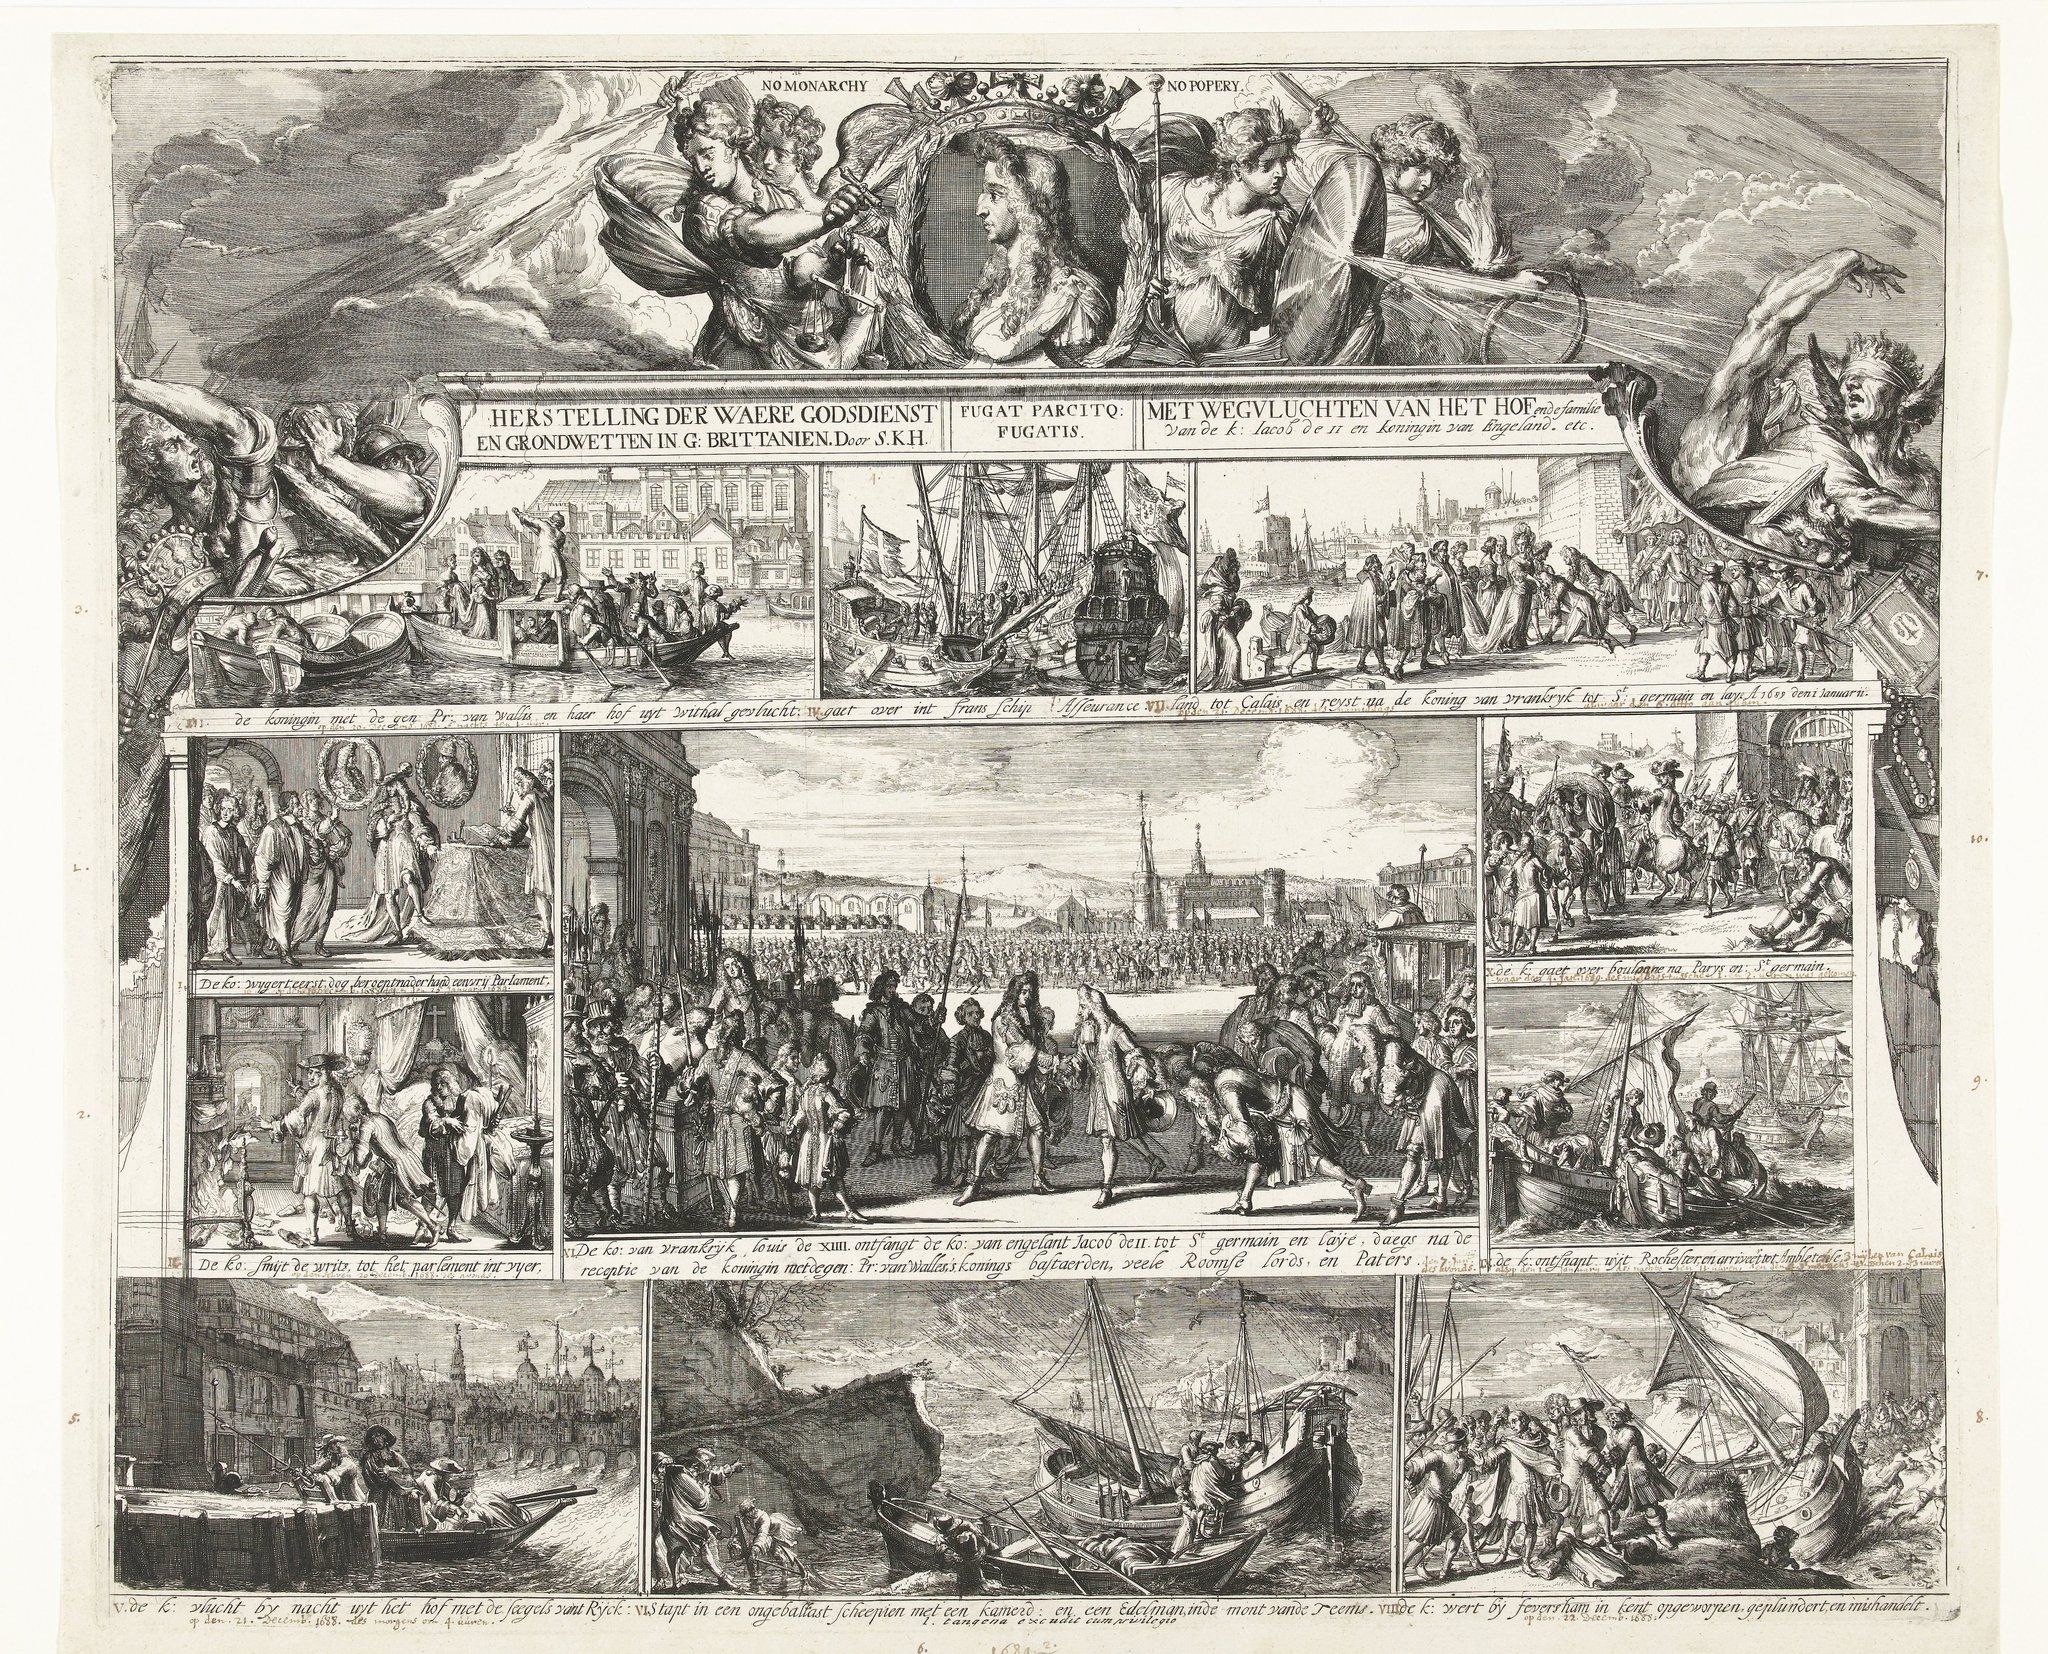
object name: print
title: Herstelling der waere godsdienst en grondwetten in G. Brittanien door S.K.H. / Met wegvluchten van het hof ende familie van de k. Iacob de II en koningin van Engeland. etc.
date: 1689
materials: paper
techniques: etching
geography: northern netherlands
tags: jacobus ii (koning van engeland en schotland), lodewijk xiv (koning van frankrijk)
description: De vlucht van de koningin Maria van Modena met de prins van Wales en de katholieke koning Jacobus II in december 1688 en januari 1689 in 11 voorstellingen. Bovenaan een portret in profiel naar links van Willem III met hierbij de leus: No Monarchy No Popery. Centraal een grote voorstelling waarin Jacobus II ontvangen wordt door de Franse koning Lodewijk XIV in Saint-Germain-en-Laye. Onder de voorstellingen korte verklaringen en toegevoegde notities met pen in bruin.